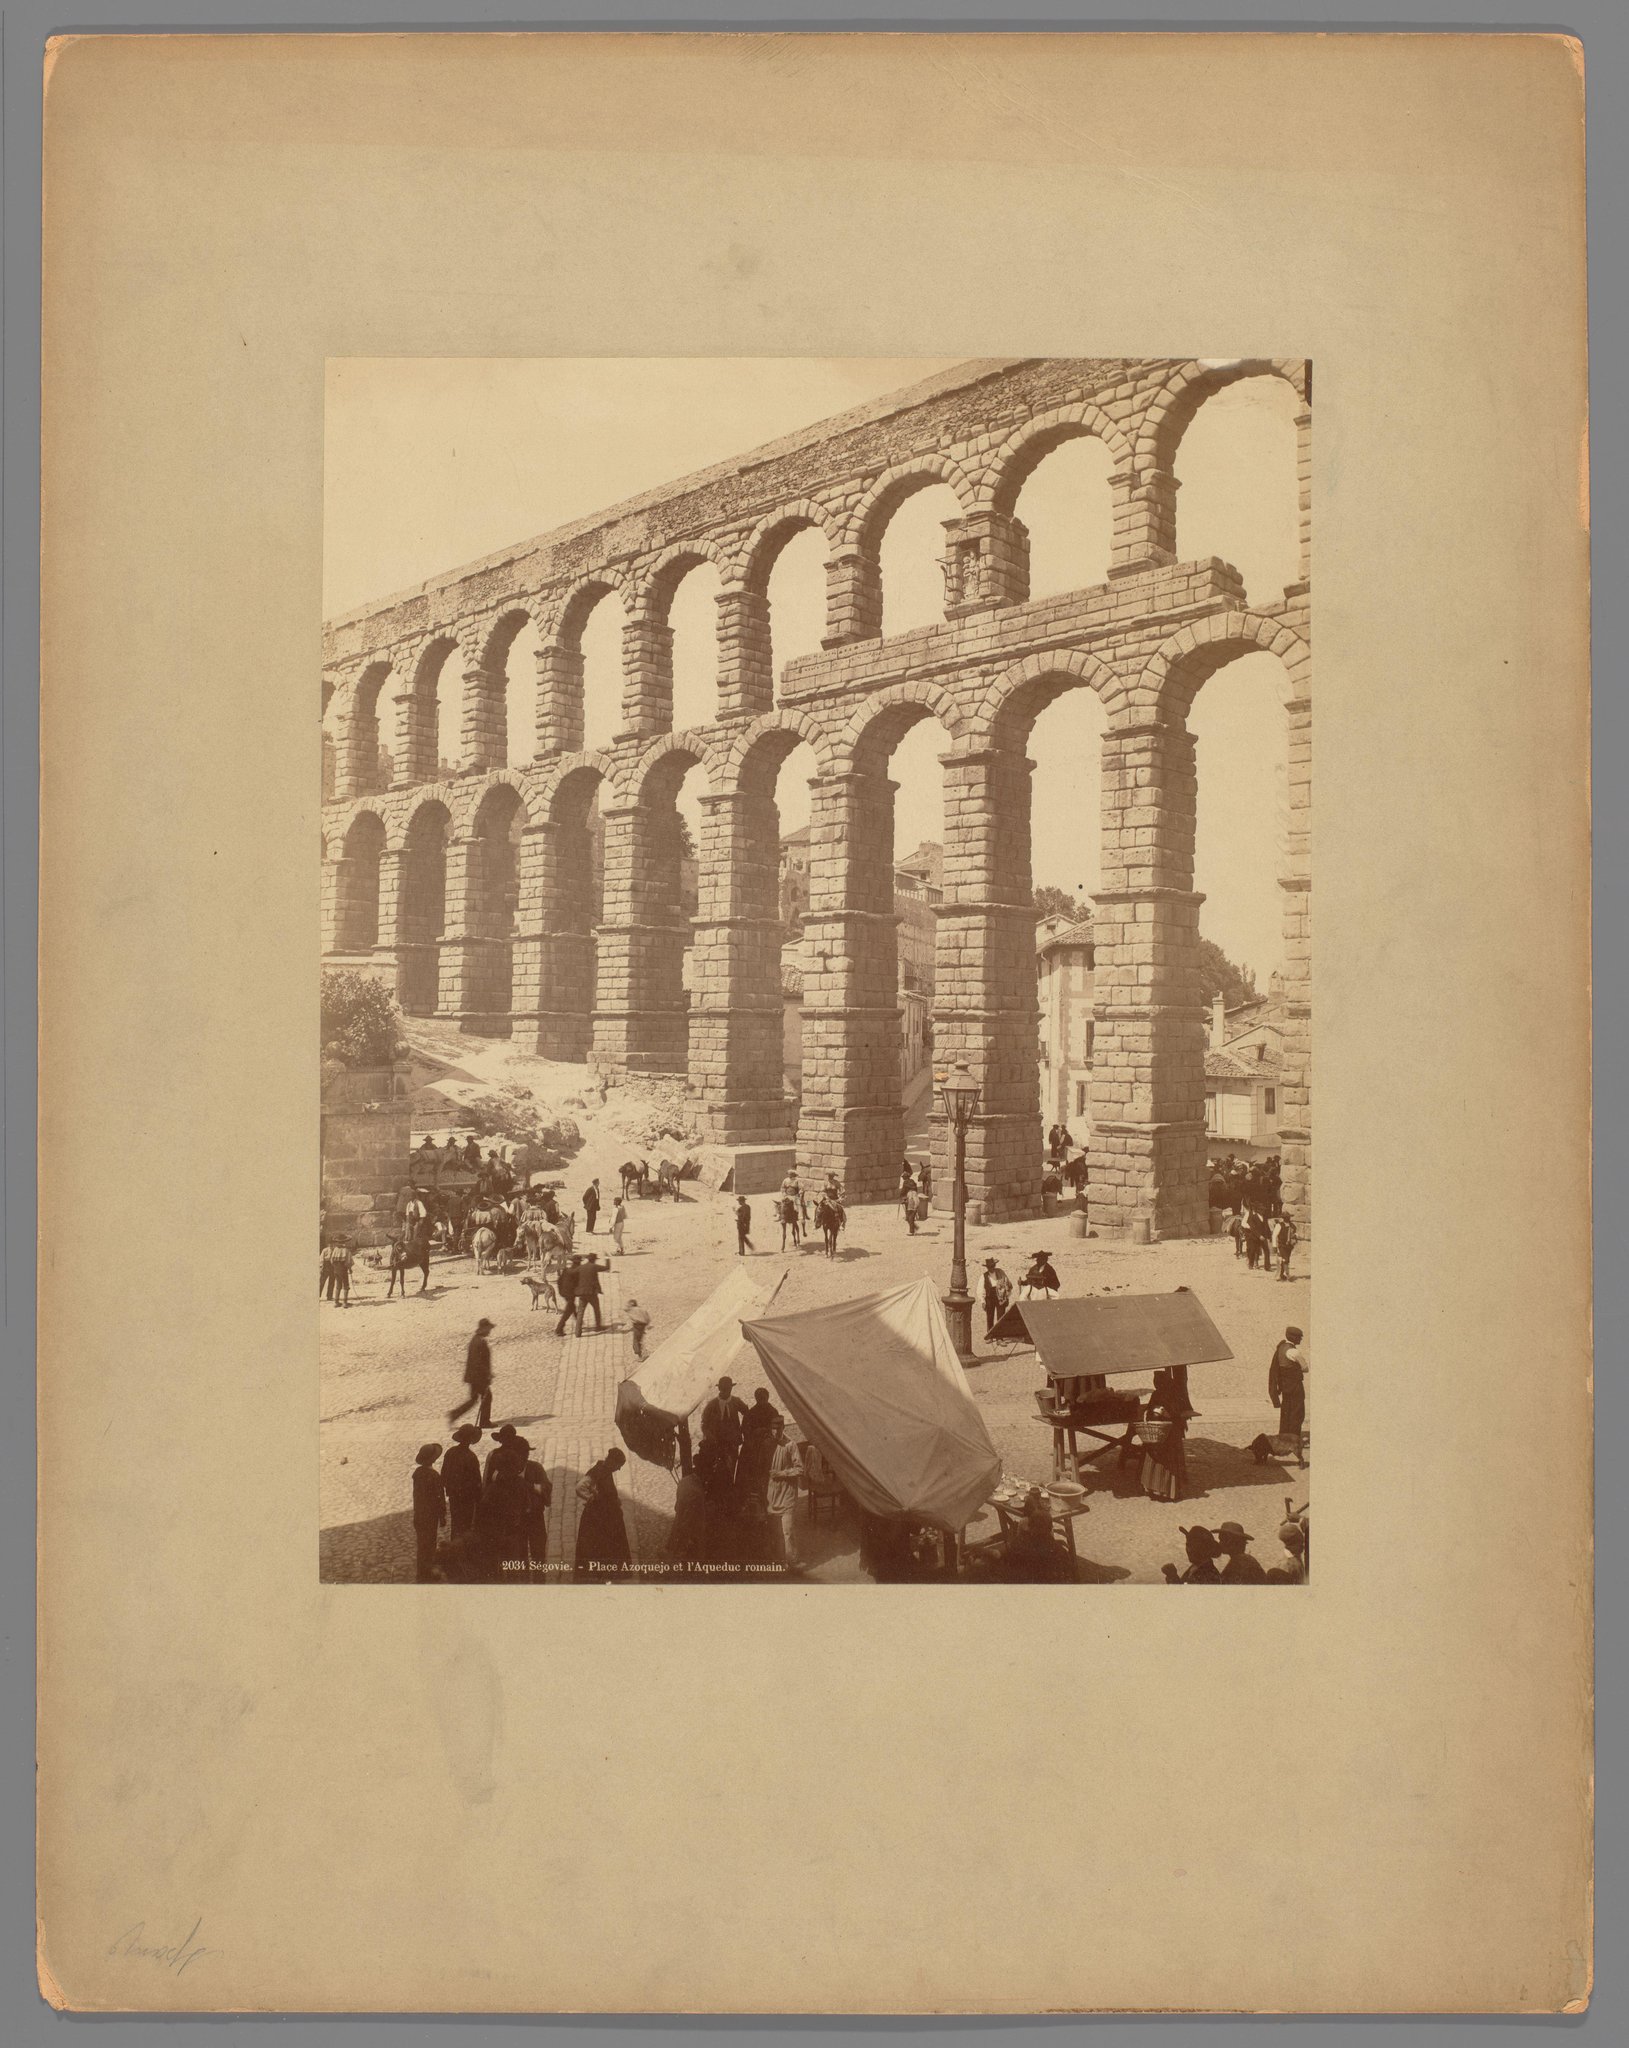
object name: photograph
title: Gezicht op het Plaza del Azoguejo en het Romeinse aquaduct te Segovia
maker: Anonymous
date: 1875-1900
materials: cardboard, photographic support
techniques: albumen print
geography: segovia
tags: square, place, circus, etc., aqueduct (~ water supply), street (+ city(-scape) with figures, staffage)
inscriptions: collector's mark: Lugt 3937, number: ‘2034’